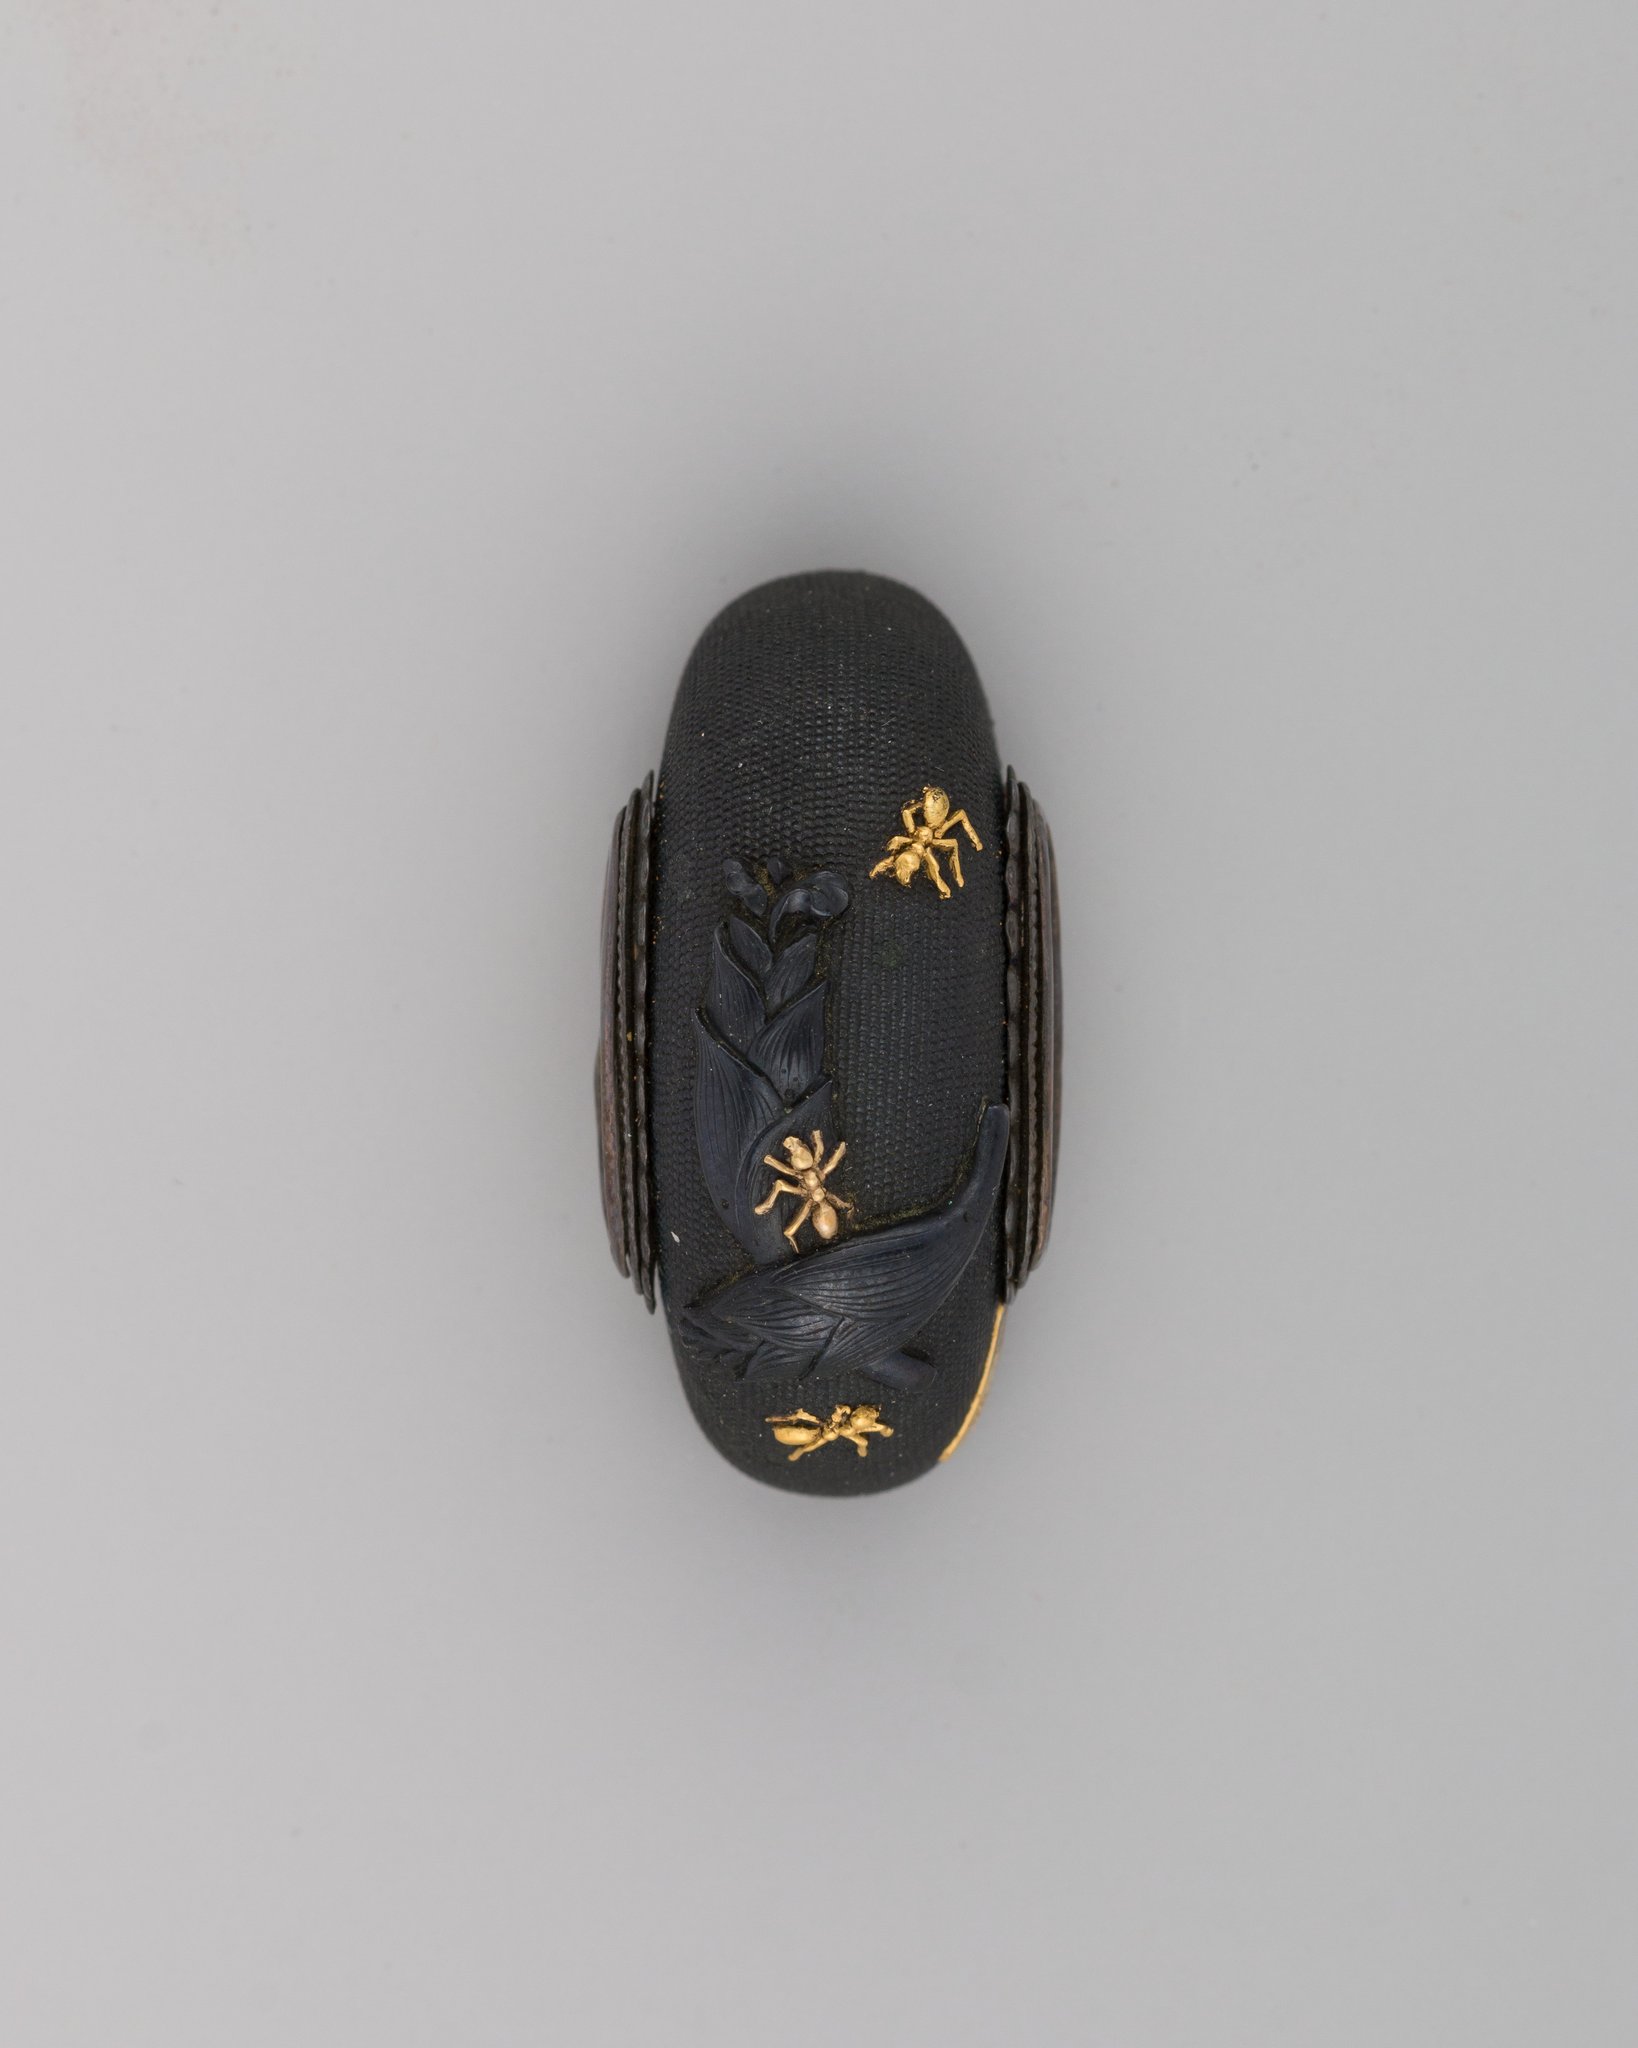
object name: cord knob kurigata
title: Cord Knob (Kurigata)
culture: japanese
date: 1801-1900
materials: gold alloy, gold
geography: japan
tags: insects